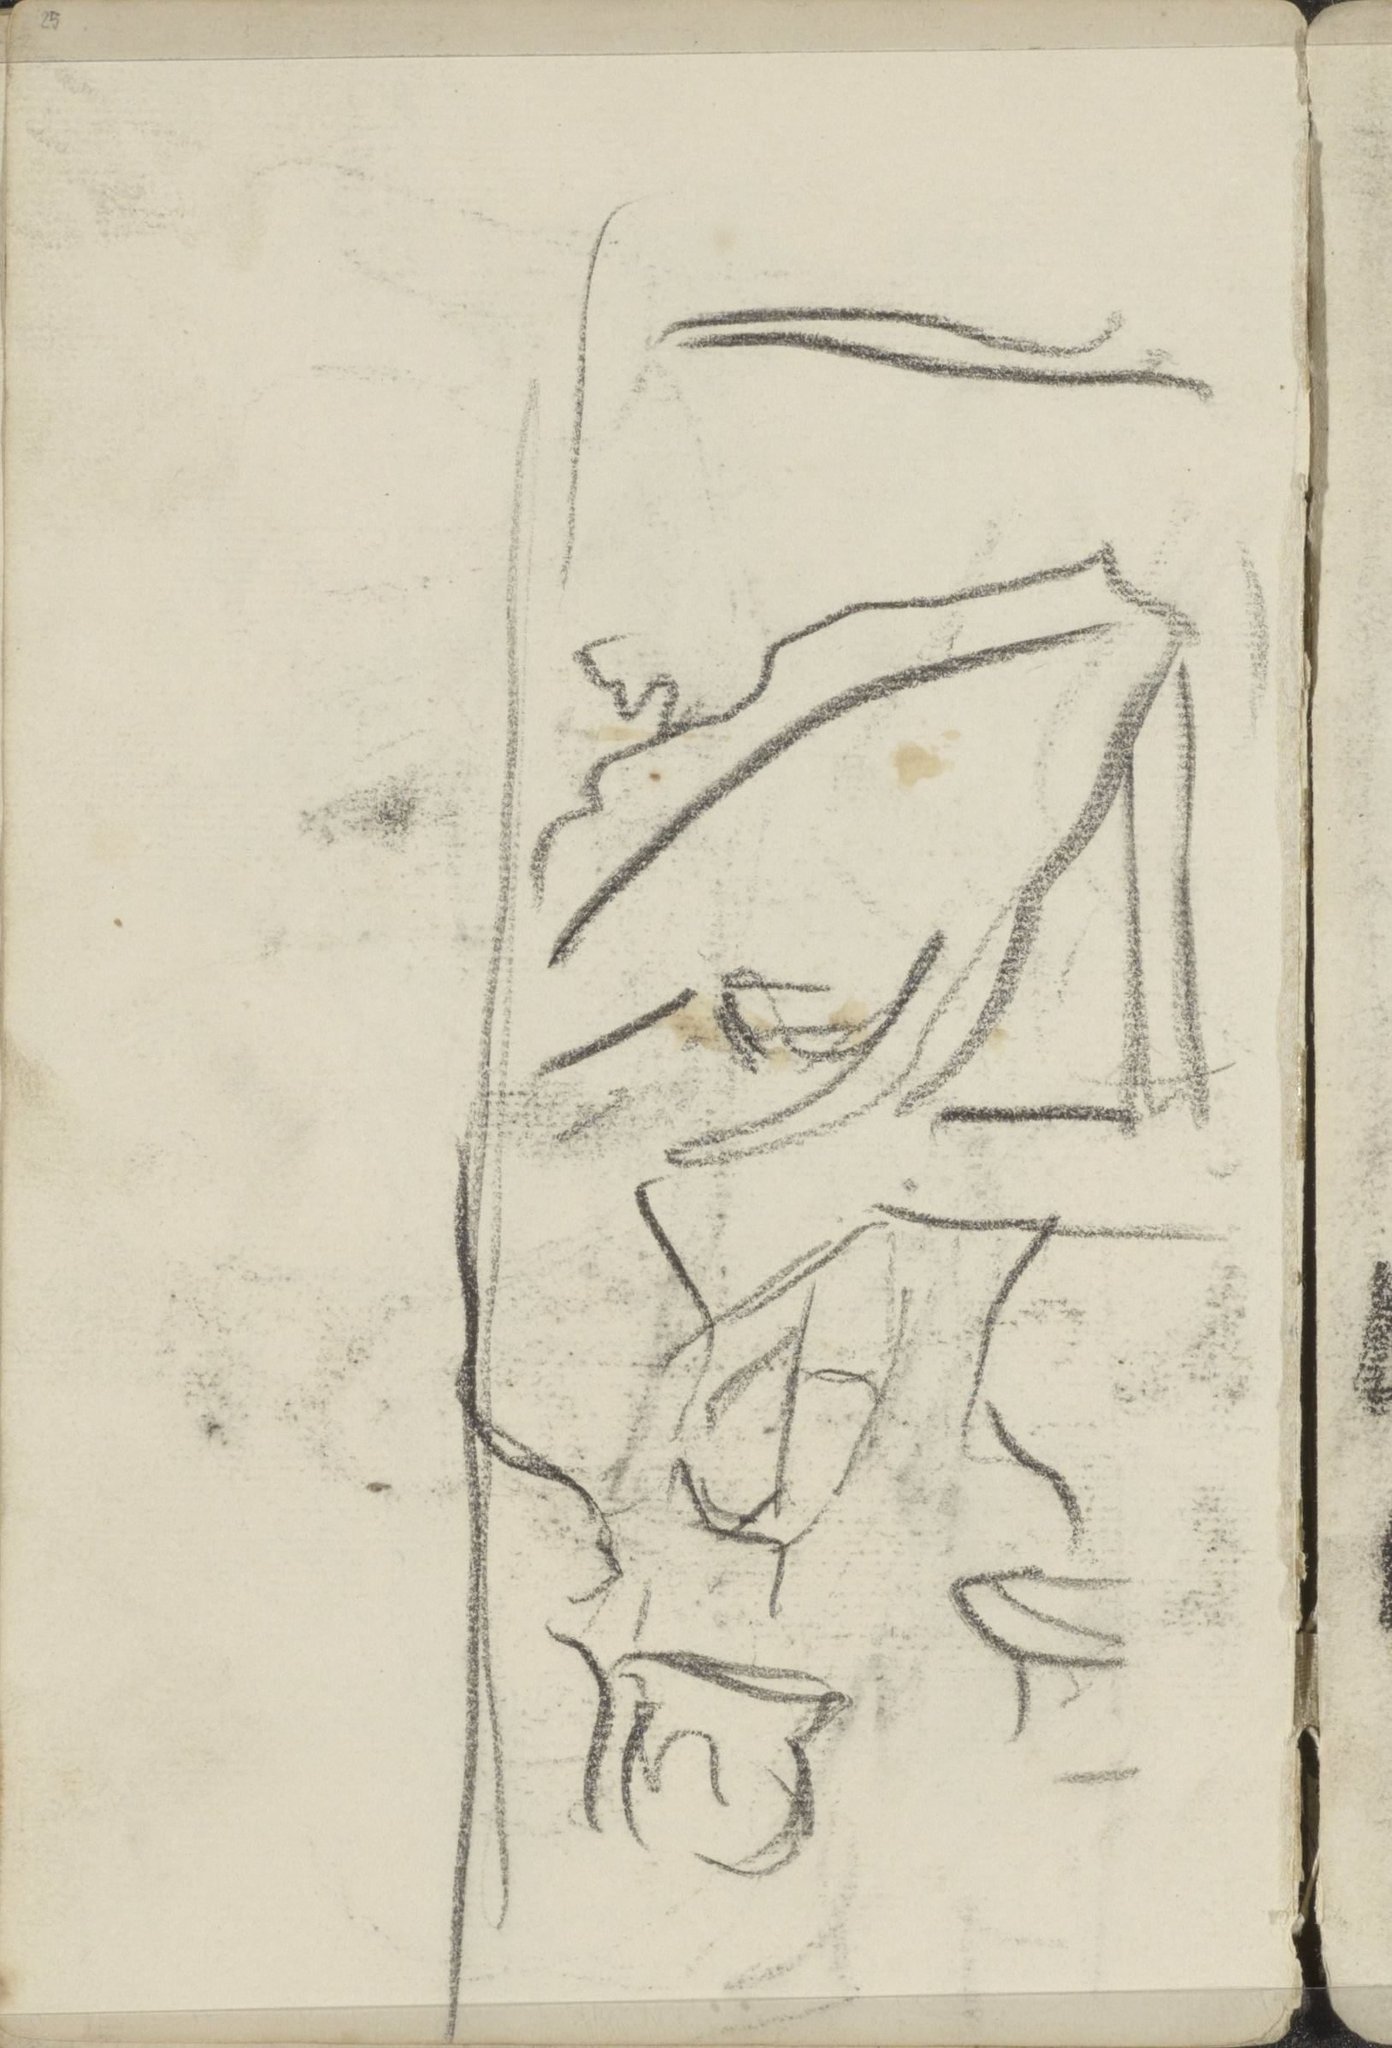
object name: sketchbook leaf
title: Zittende vrouw met hoed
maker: george hendrik breitner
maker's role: draughtsman, painter, print maker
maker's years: 1857-1923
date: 1886-1903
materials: chalk, paper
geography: amsterdam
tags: head-gear: hat (+ women's clothes), sitting on an elevation - aa - female human figure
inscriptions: kleurnotitie, handgeschreven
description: Haar hoofd rust op haar hand. Pagina 25 uit een schetsboek met 15 bladen.